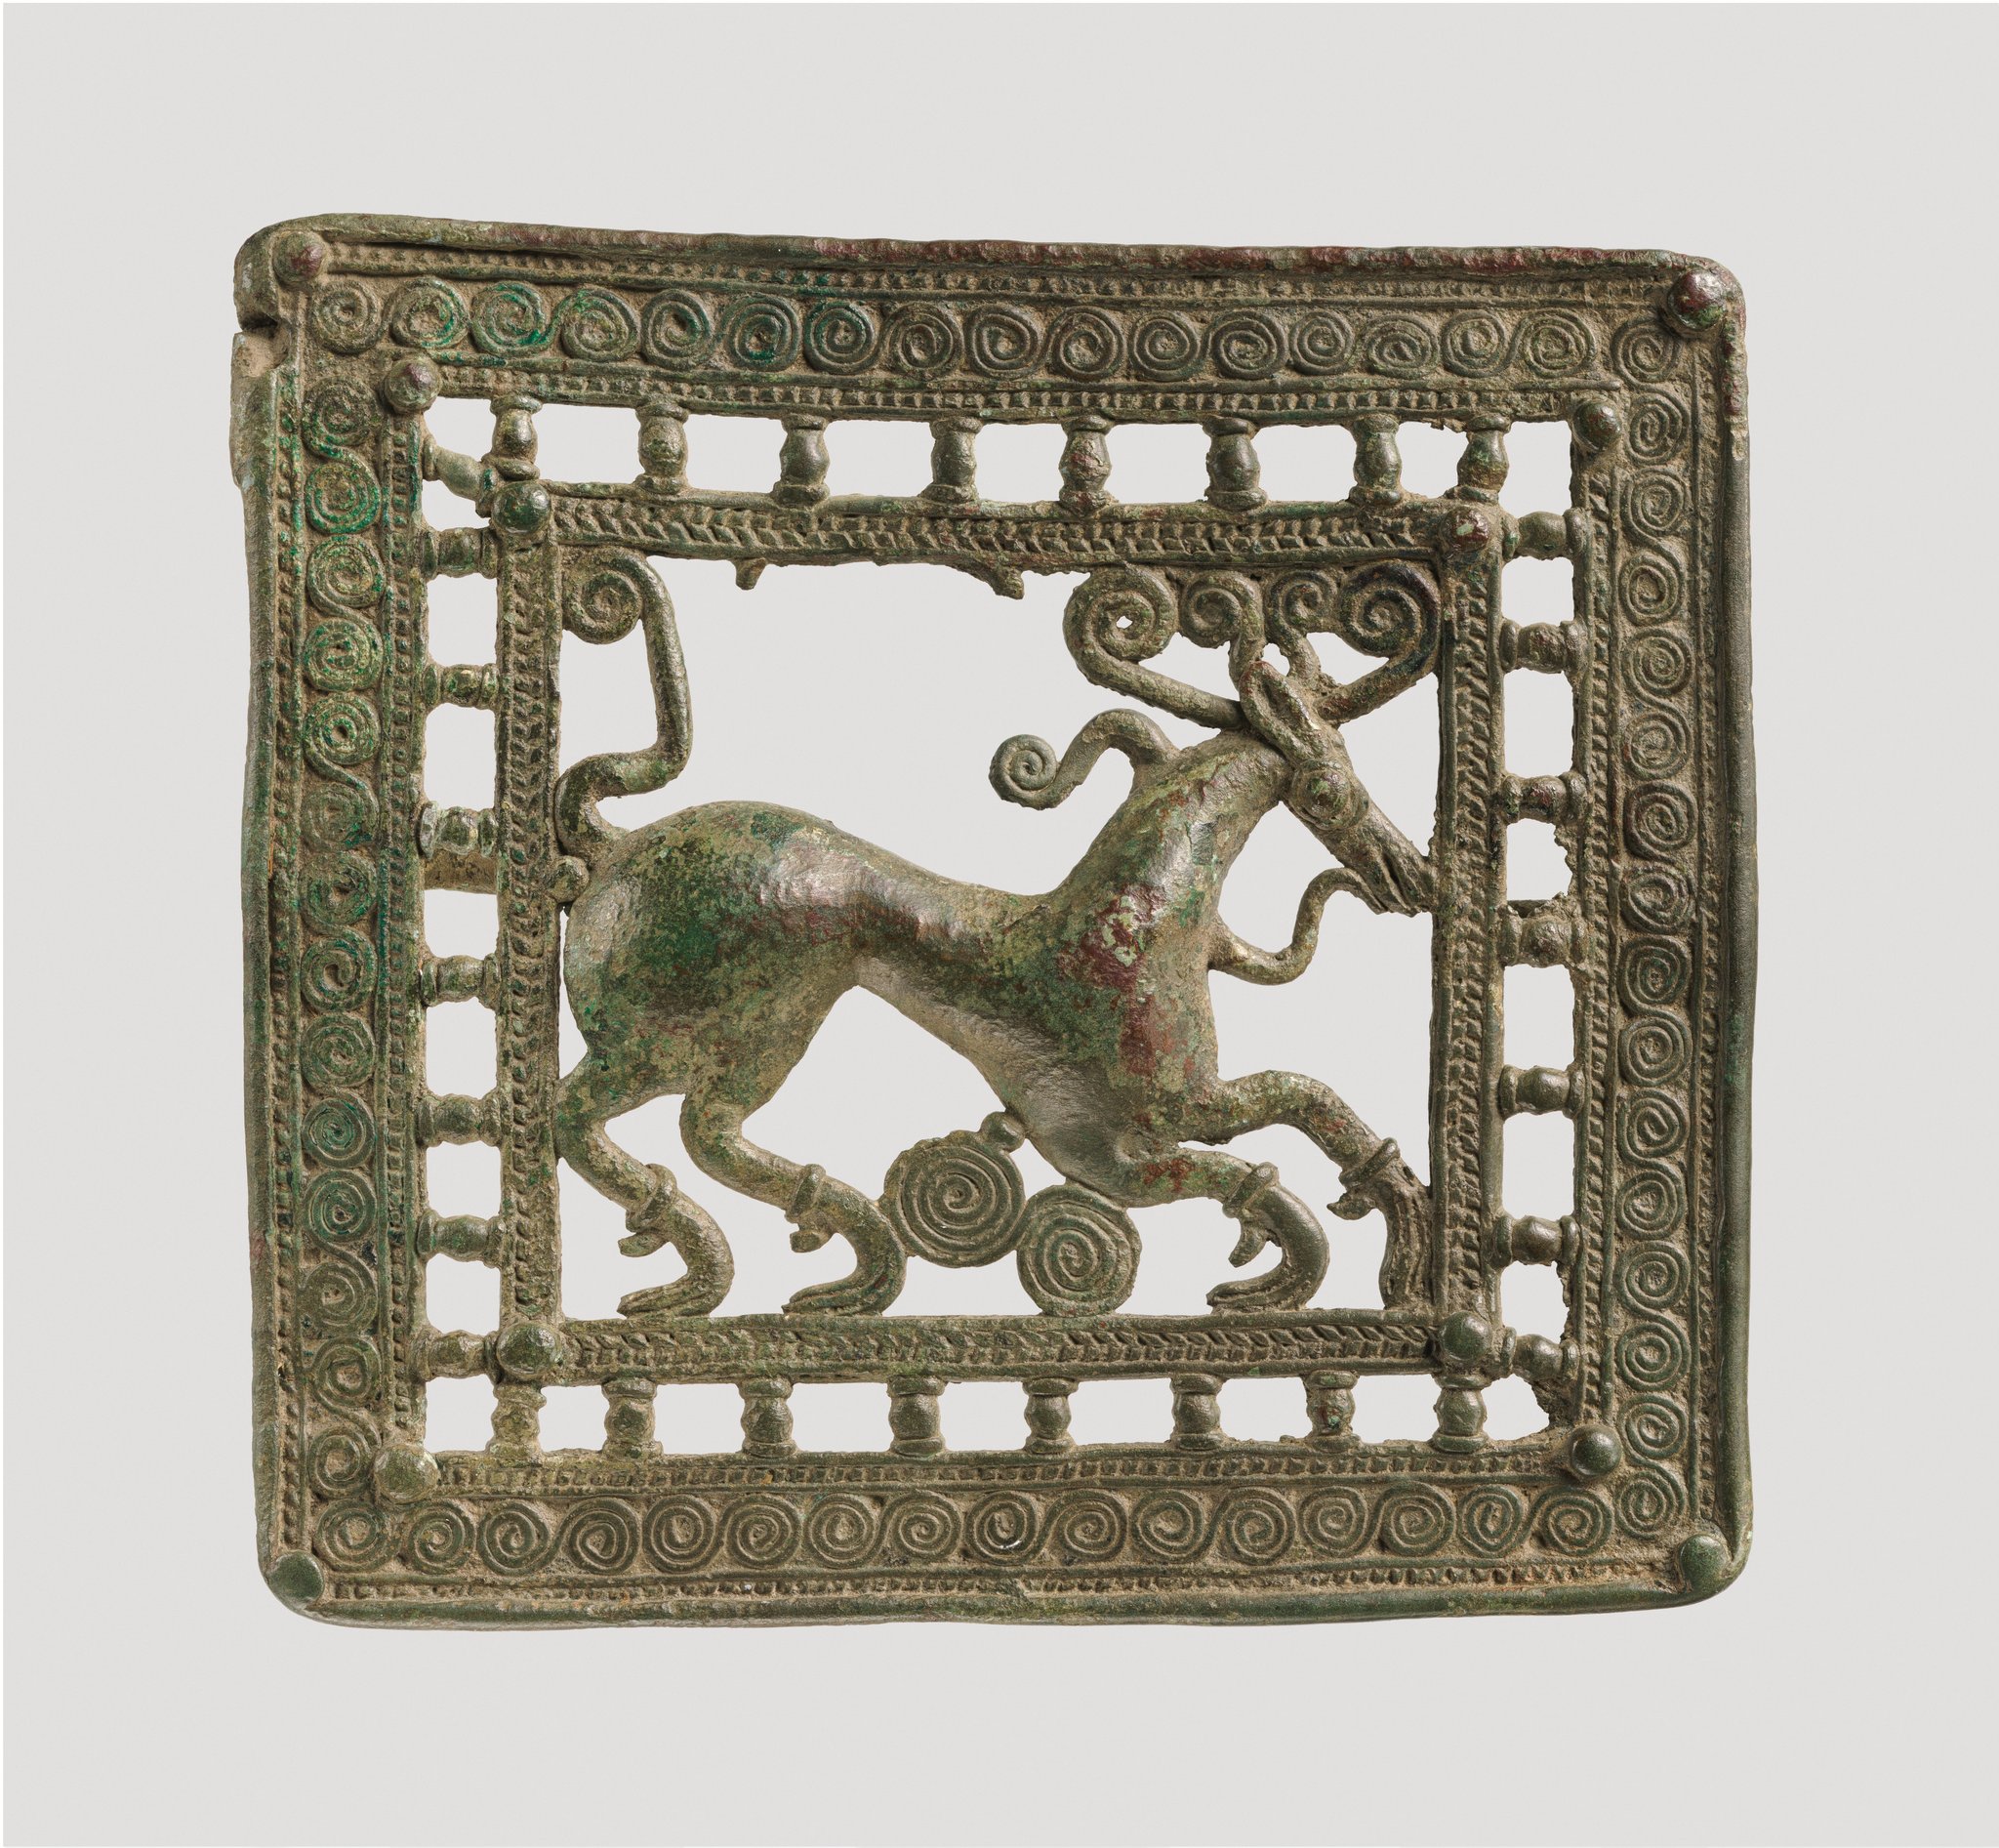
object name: belt clasp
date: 1-200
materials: brass, bronze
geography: transcaucasia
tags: animals